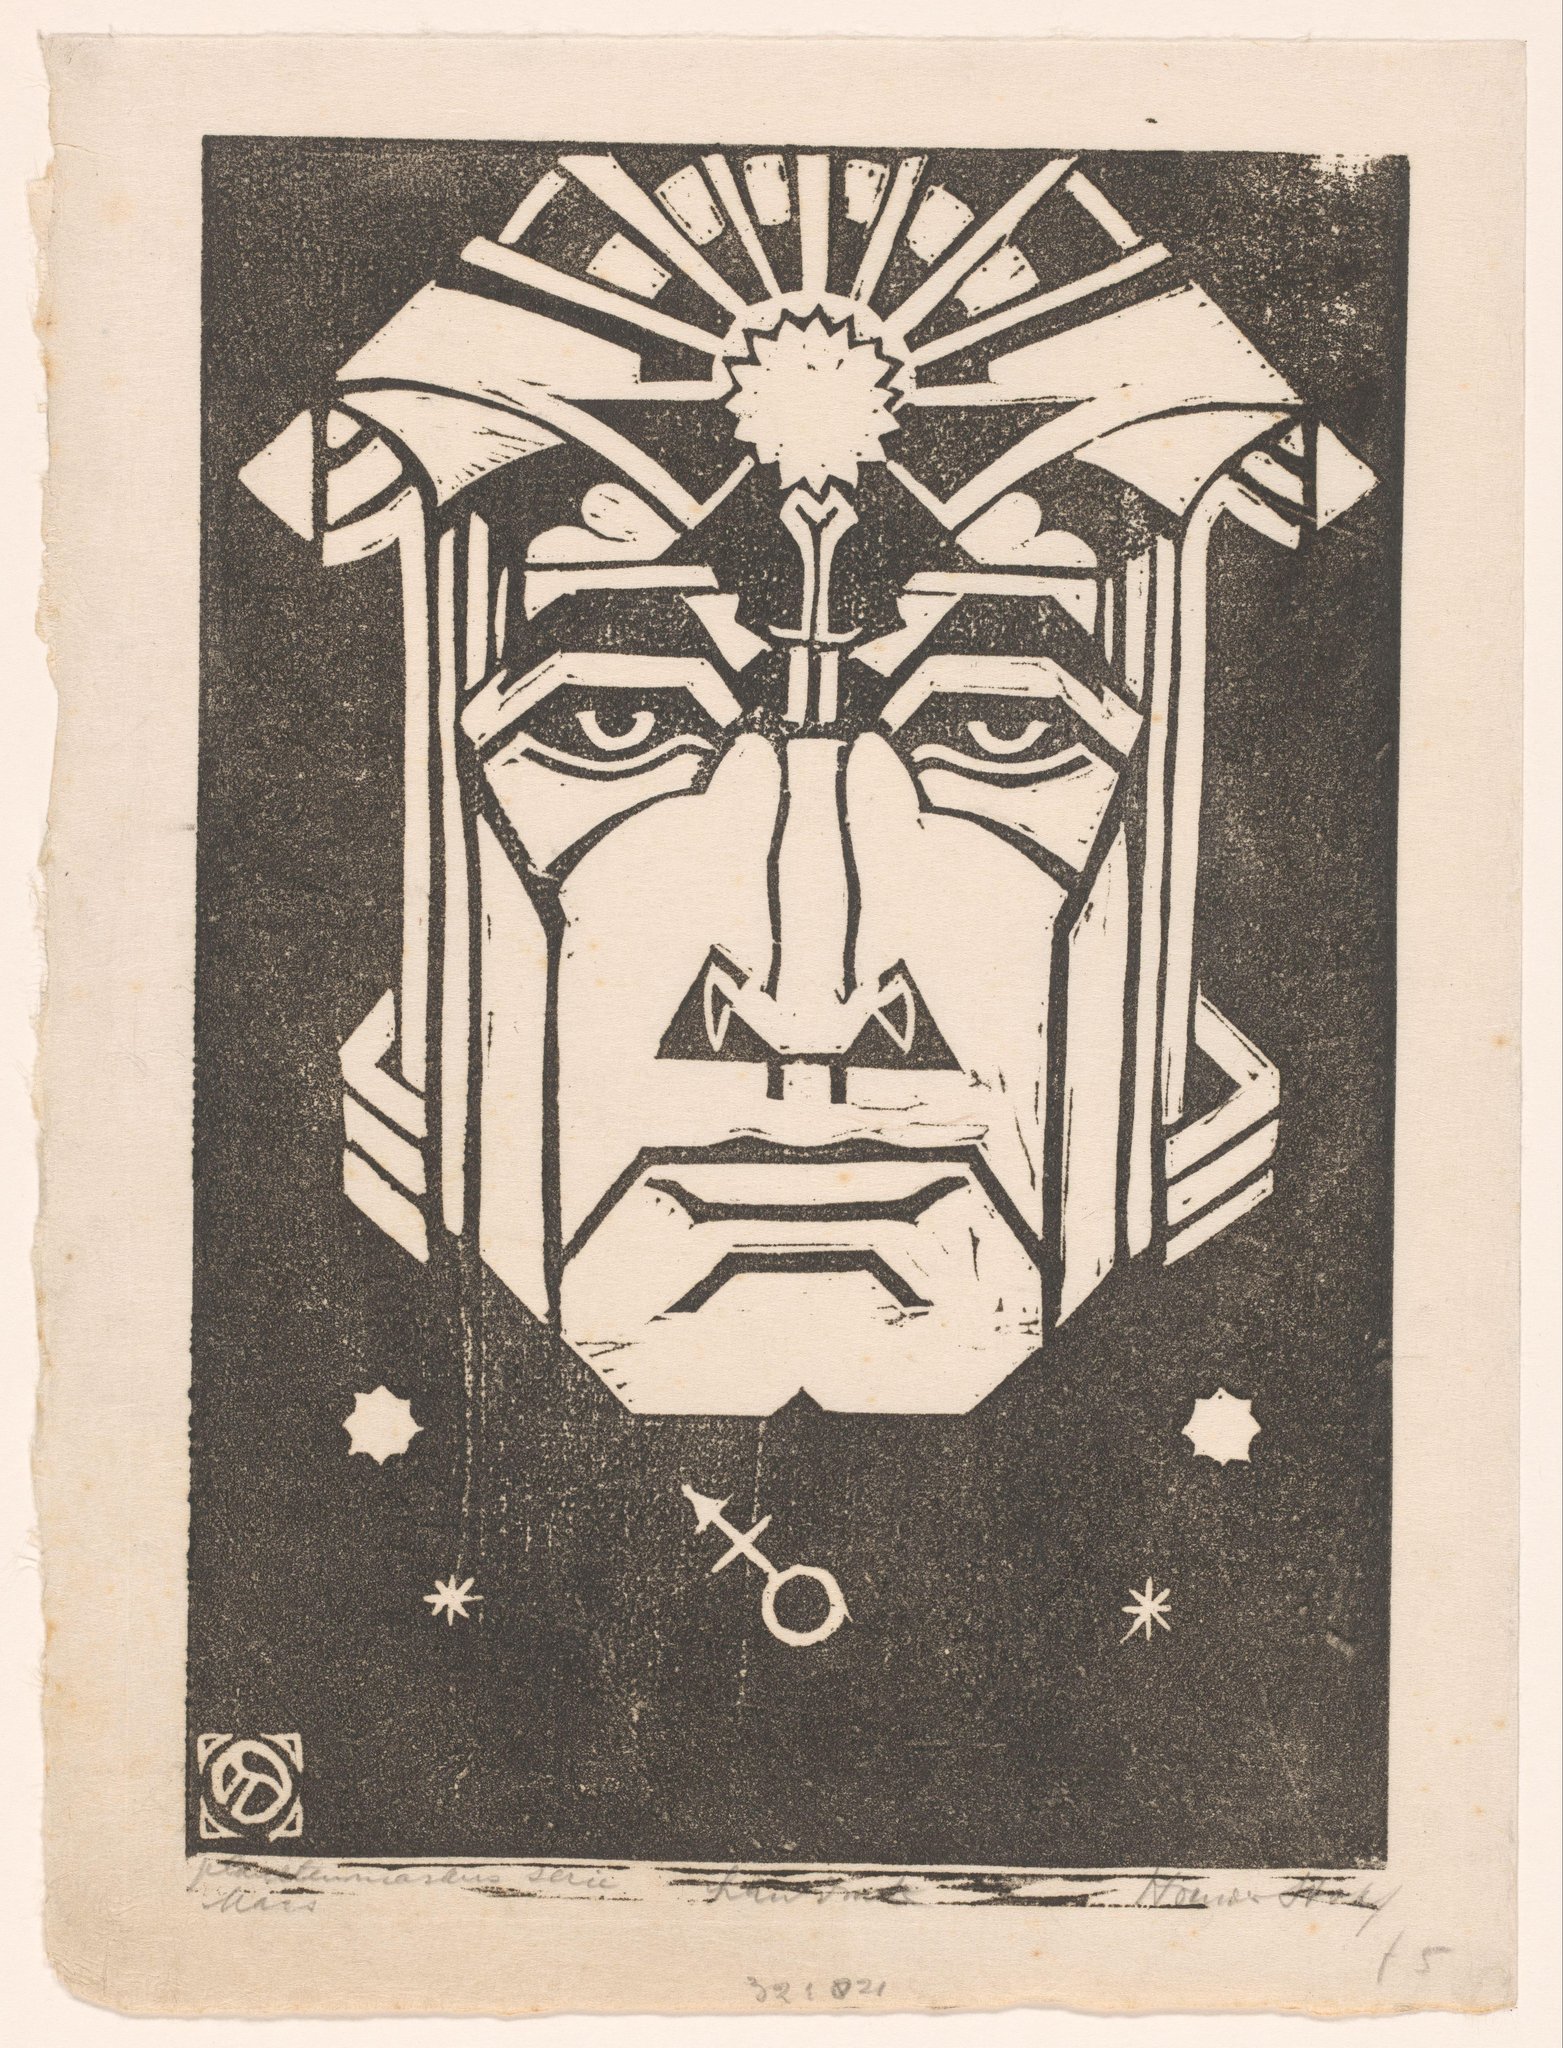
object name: print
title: Mars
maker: henri van der stok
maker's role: print maker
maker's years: 1870-1946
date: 1880-1932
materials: paper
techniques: woodcut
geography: netherlands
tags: mask, mars (planet)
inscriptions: collector's mark: Lugt 2228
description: Een masker met onderaan het symbool voor Mars.